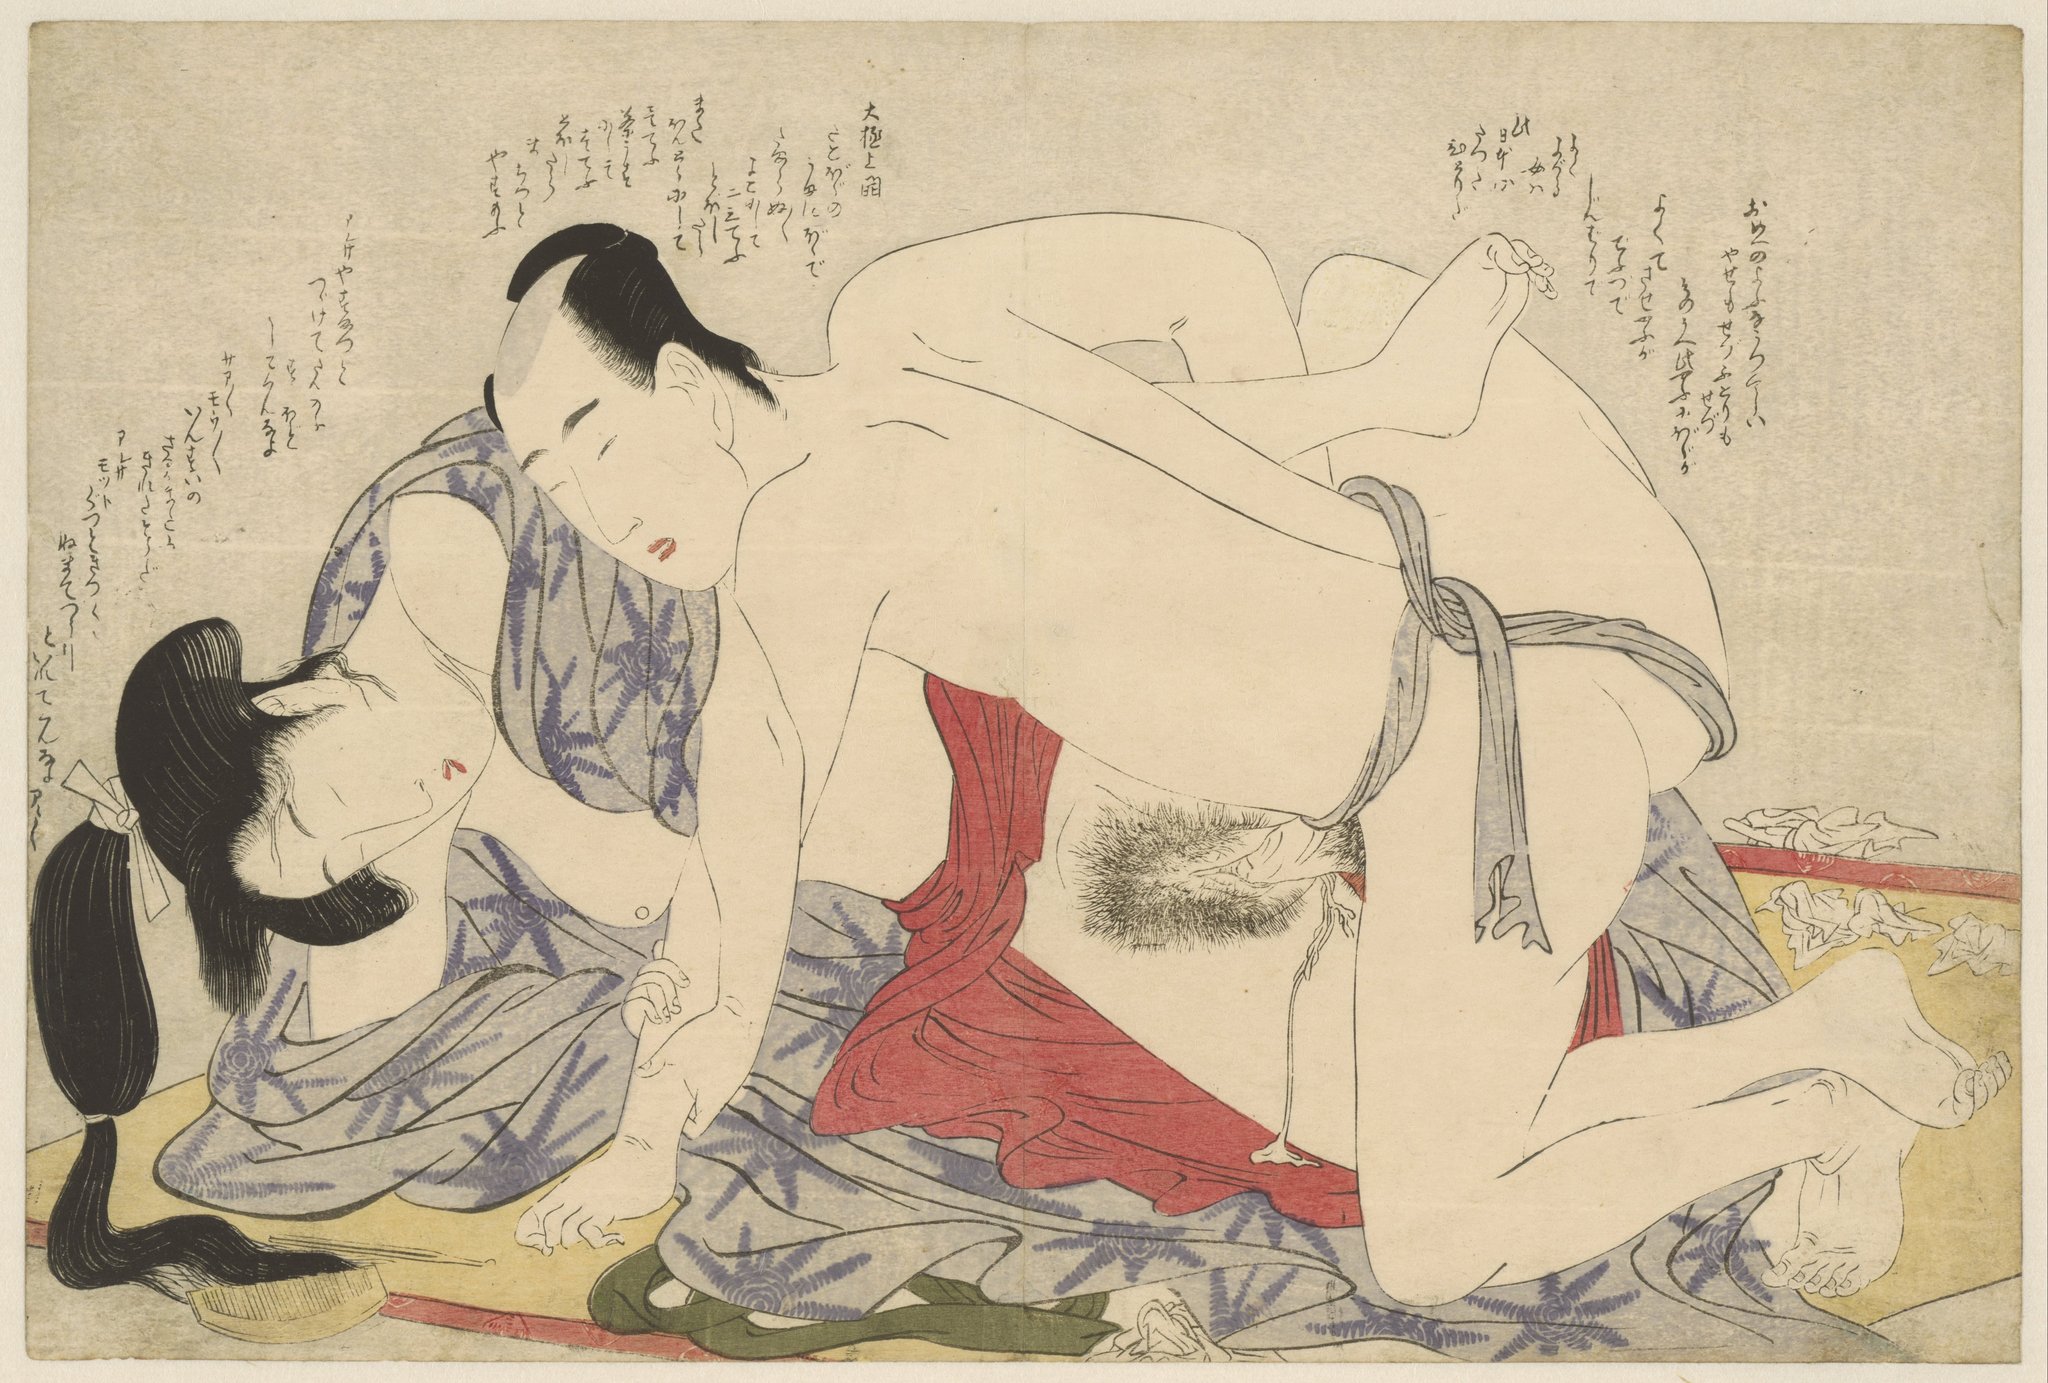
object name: shunga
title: Negai no itoguchi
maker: kitagawa utamaro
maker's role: print maker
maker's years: 1753-1806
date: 1799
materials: paper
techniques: woodcut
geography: japan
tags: coitus, cohabiting, sexual intercourse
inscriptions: collector's mark: Lugt 2760, collector's mark: Lugt 2228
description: Man en vrouw bedrijven de liefde op een geel kleed. De man is slechts gekleed in een lendendoek. Het bijeengebonden haar van de vrouw valt voorover op de vloer, naast een kam. Elfde van dertien prenten uit het album Negai no itoguchi (ook wel vertaald met: The prelude to desire).